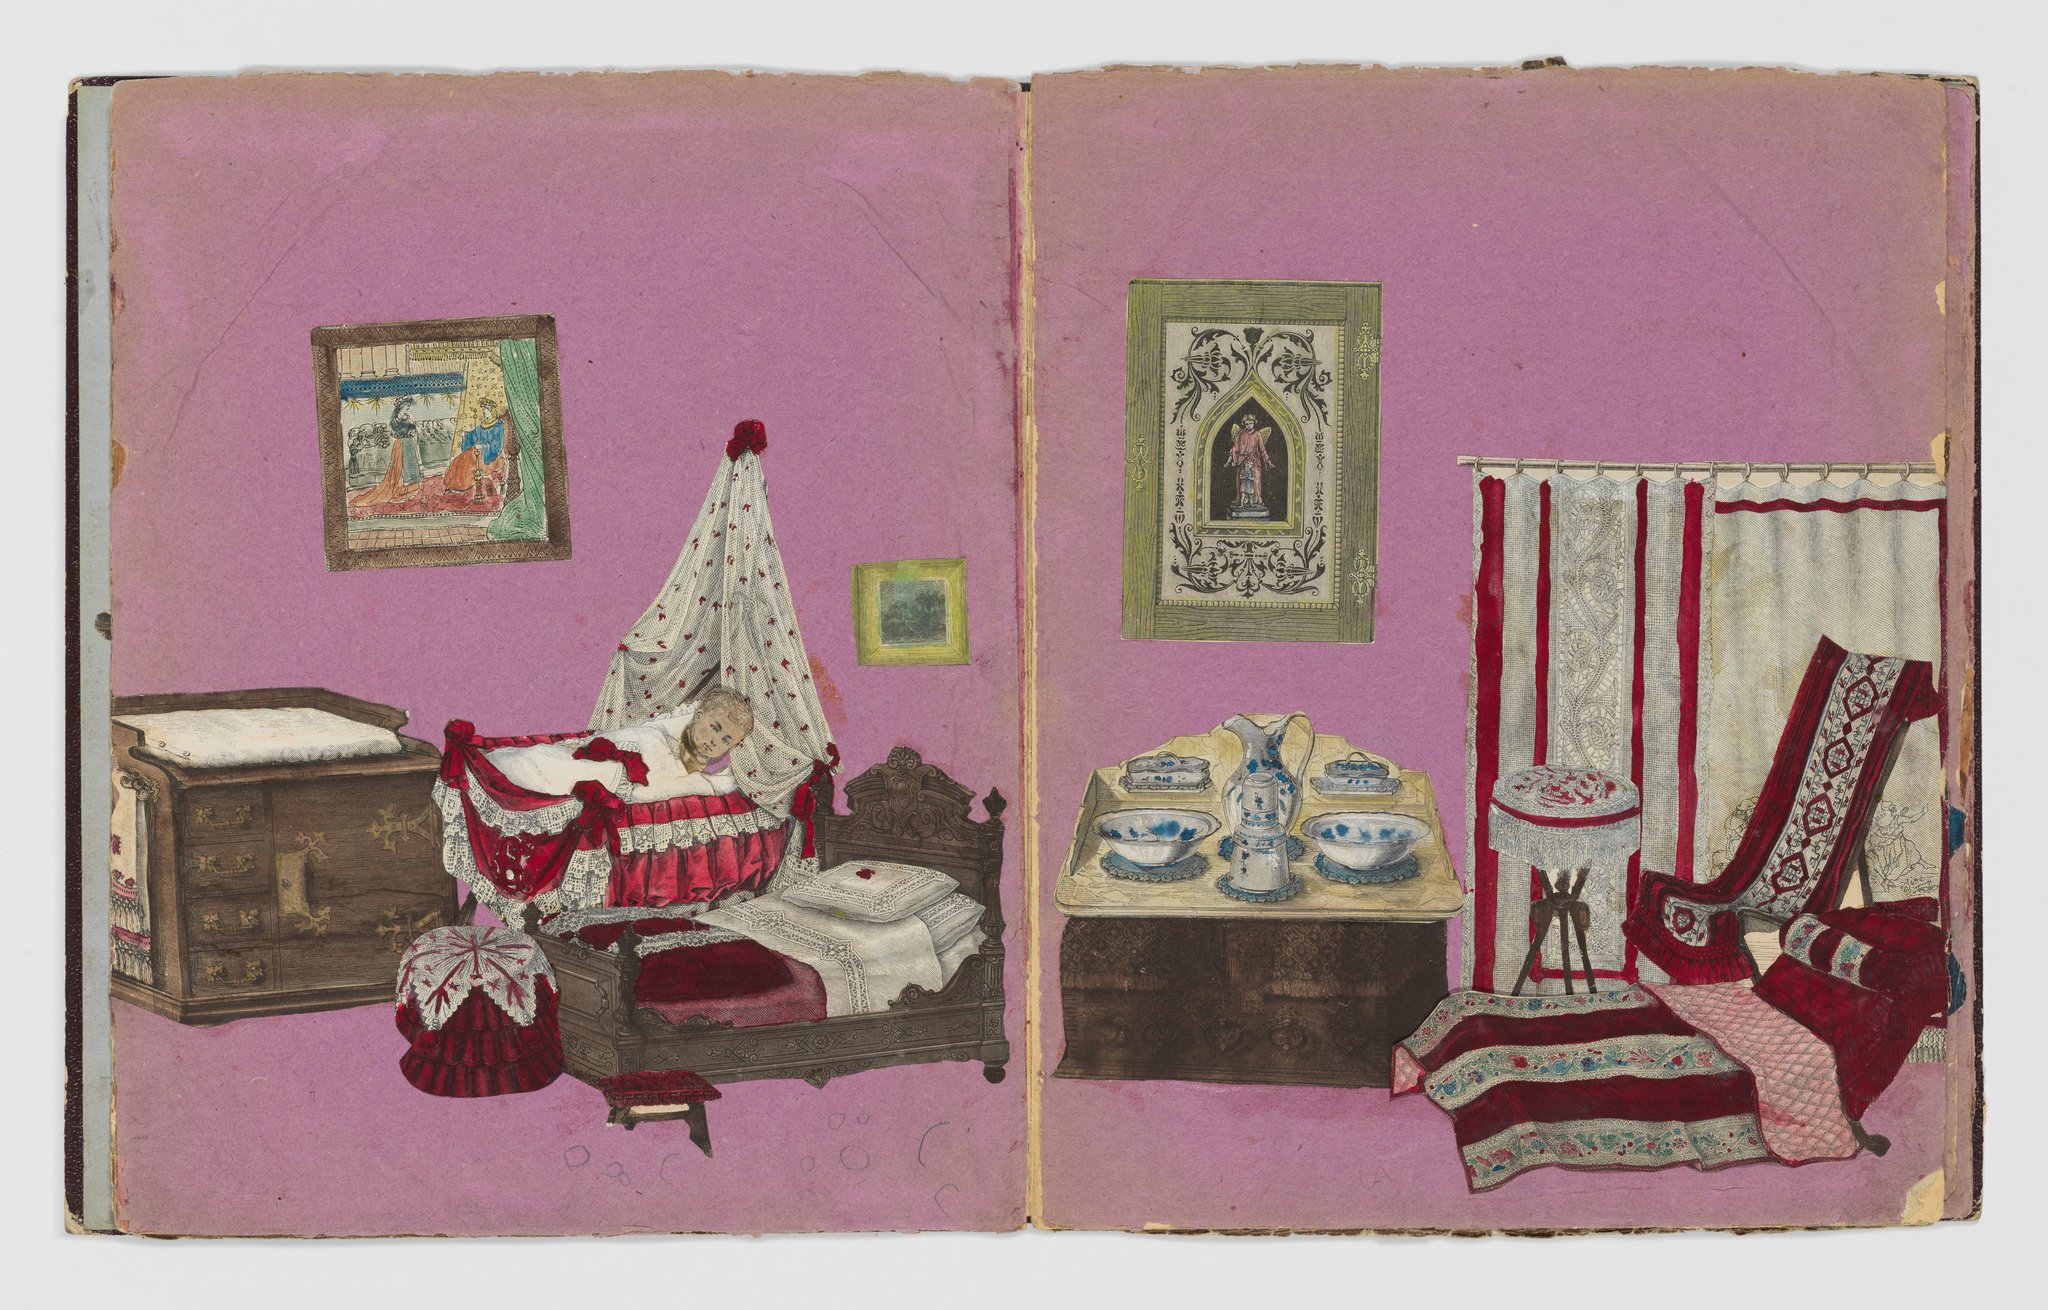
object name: album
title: Paper Doll Nursery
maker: anonymous, german, 19th century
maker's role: artist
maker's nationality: german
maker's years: 1800-1899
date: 1883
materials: paper, wood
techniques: cutting, engraving, hand coloring, printing